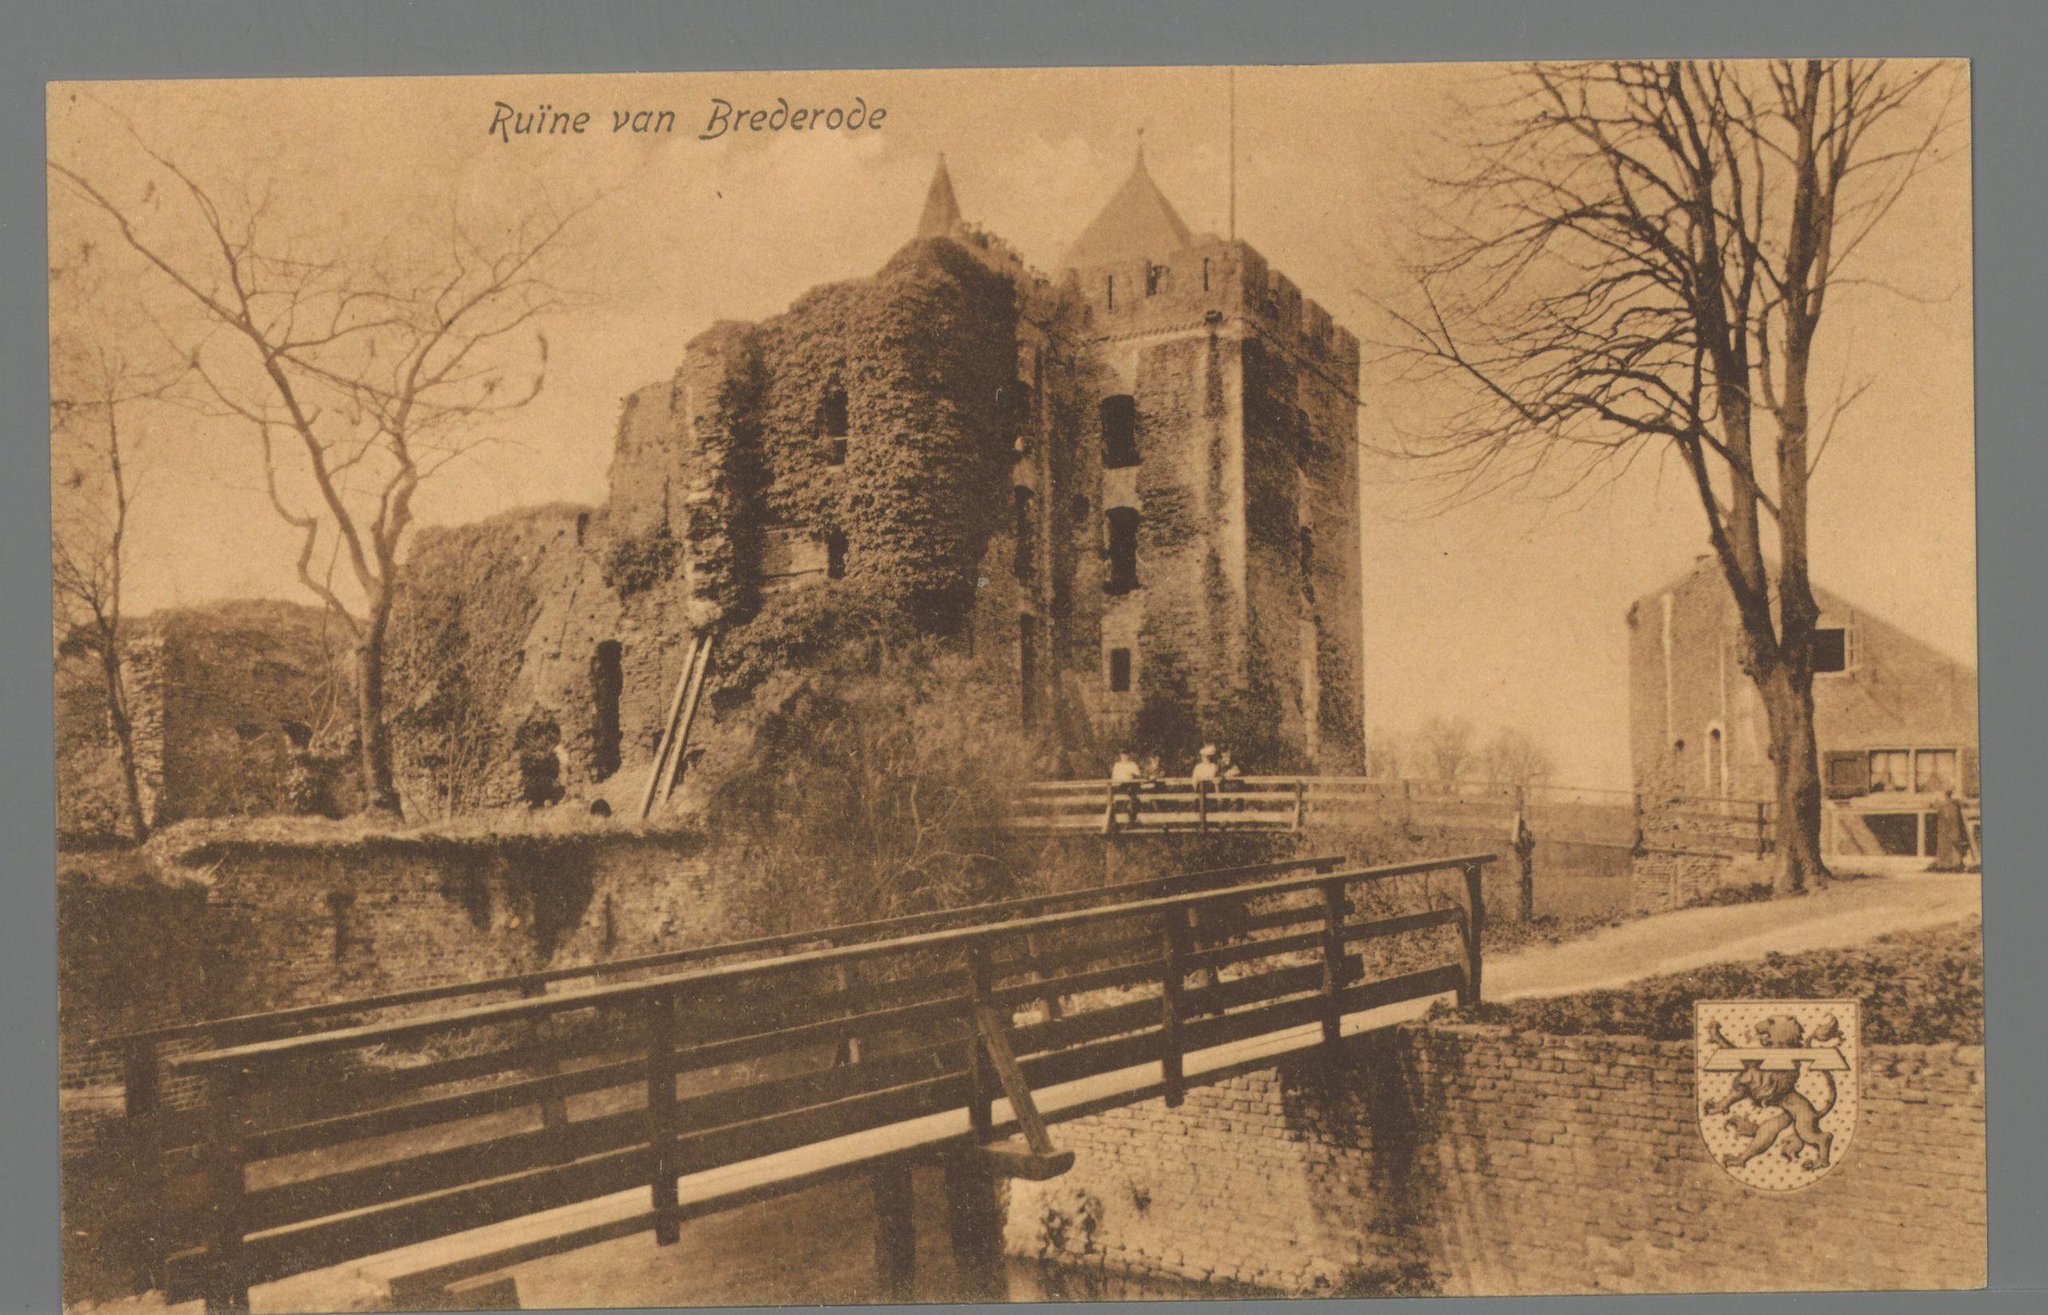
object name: photomechanical print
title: Ruïne van Brederode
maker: Anonymous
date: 1912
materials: cardboard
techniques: photograph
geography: leipzig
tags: castle, bridge in city across river, canal, etc., armorial bearing, heraldry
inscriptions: date